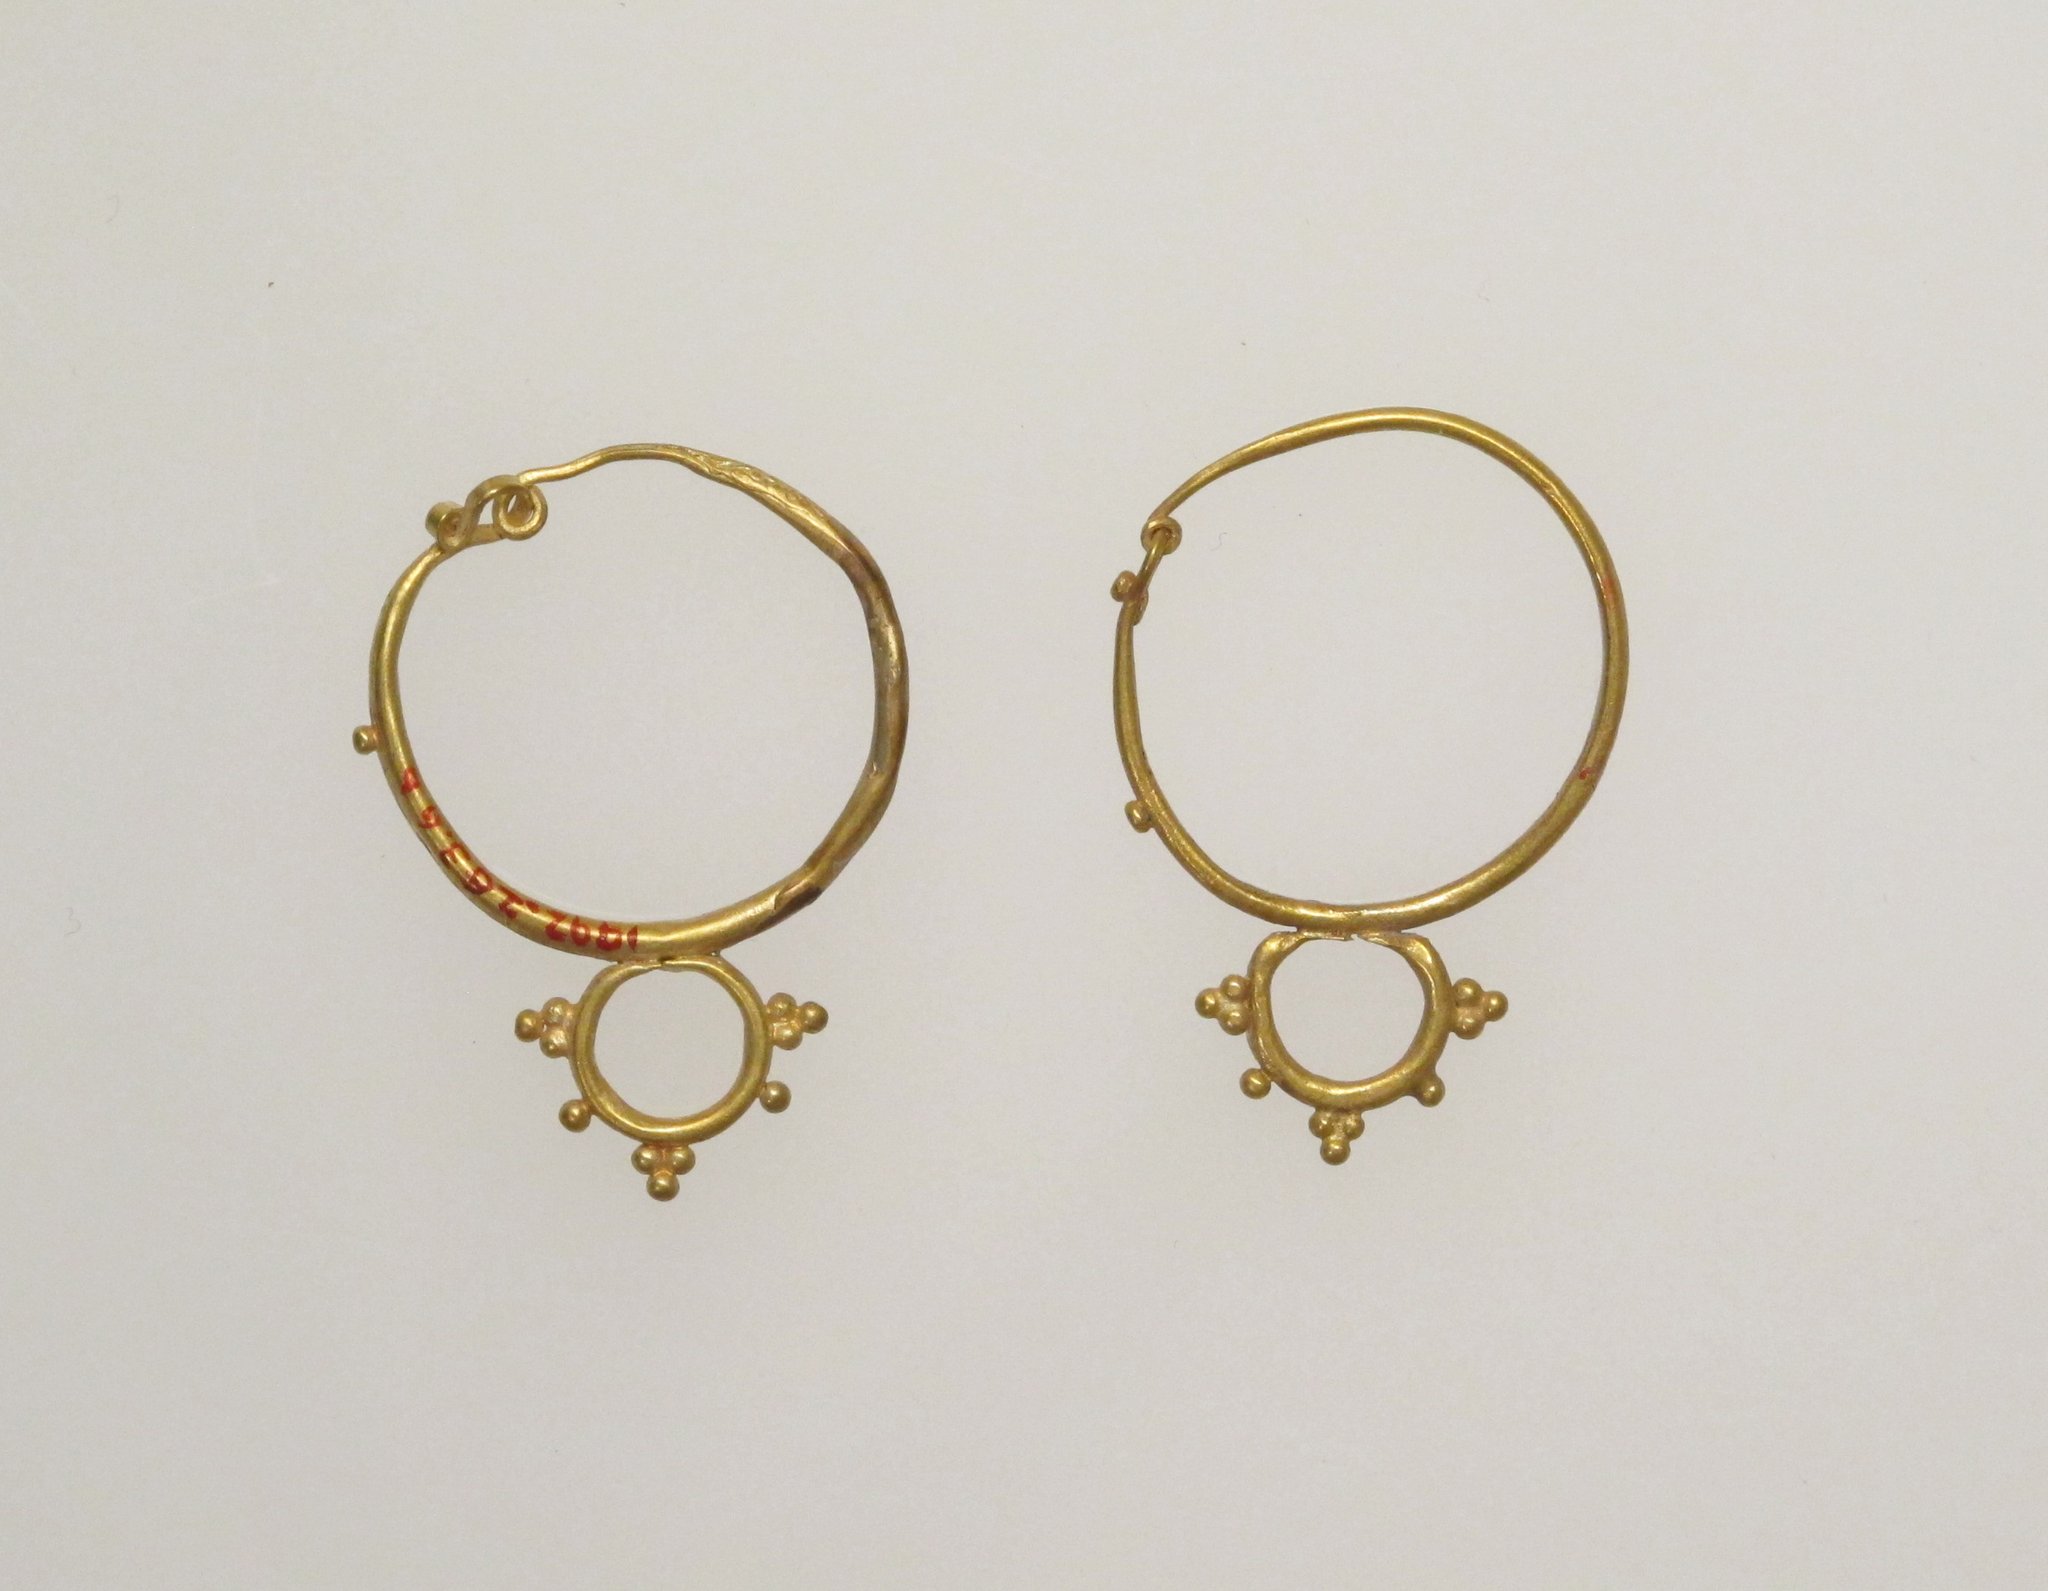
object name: earring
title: Earrings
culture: roman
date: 501-600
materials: gold